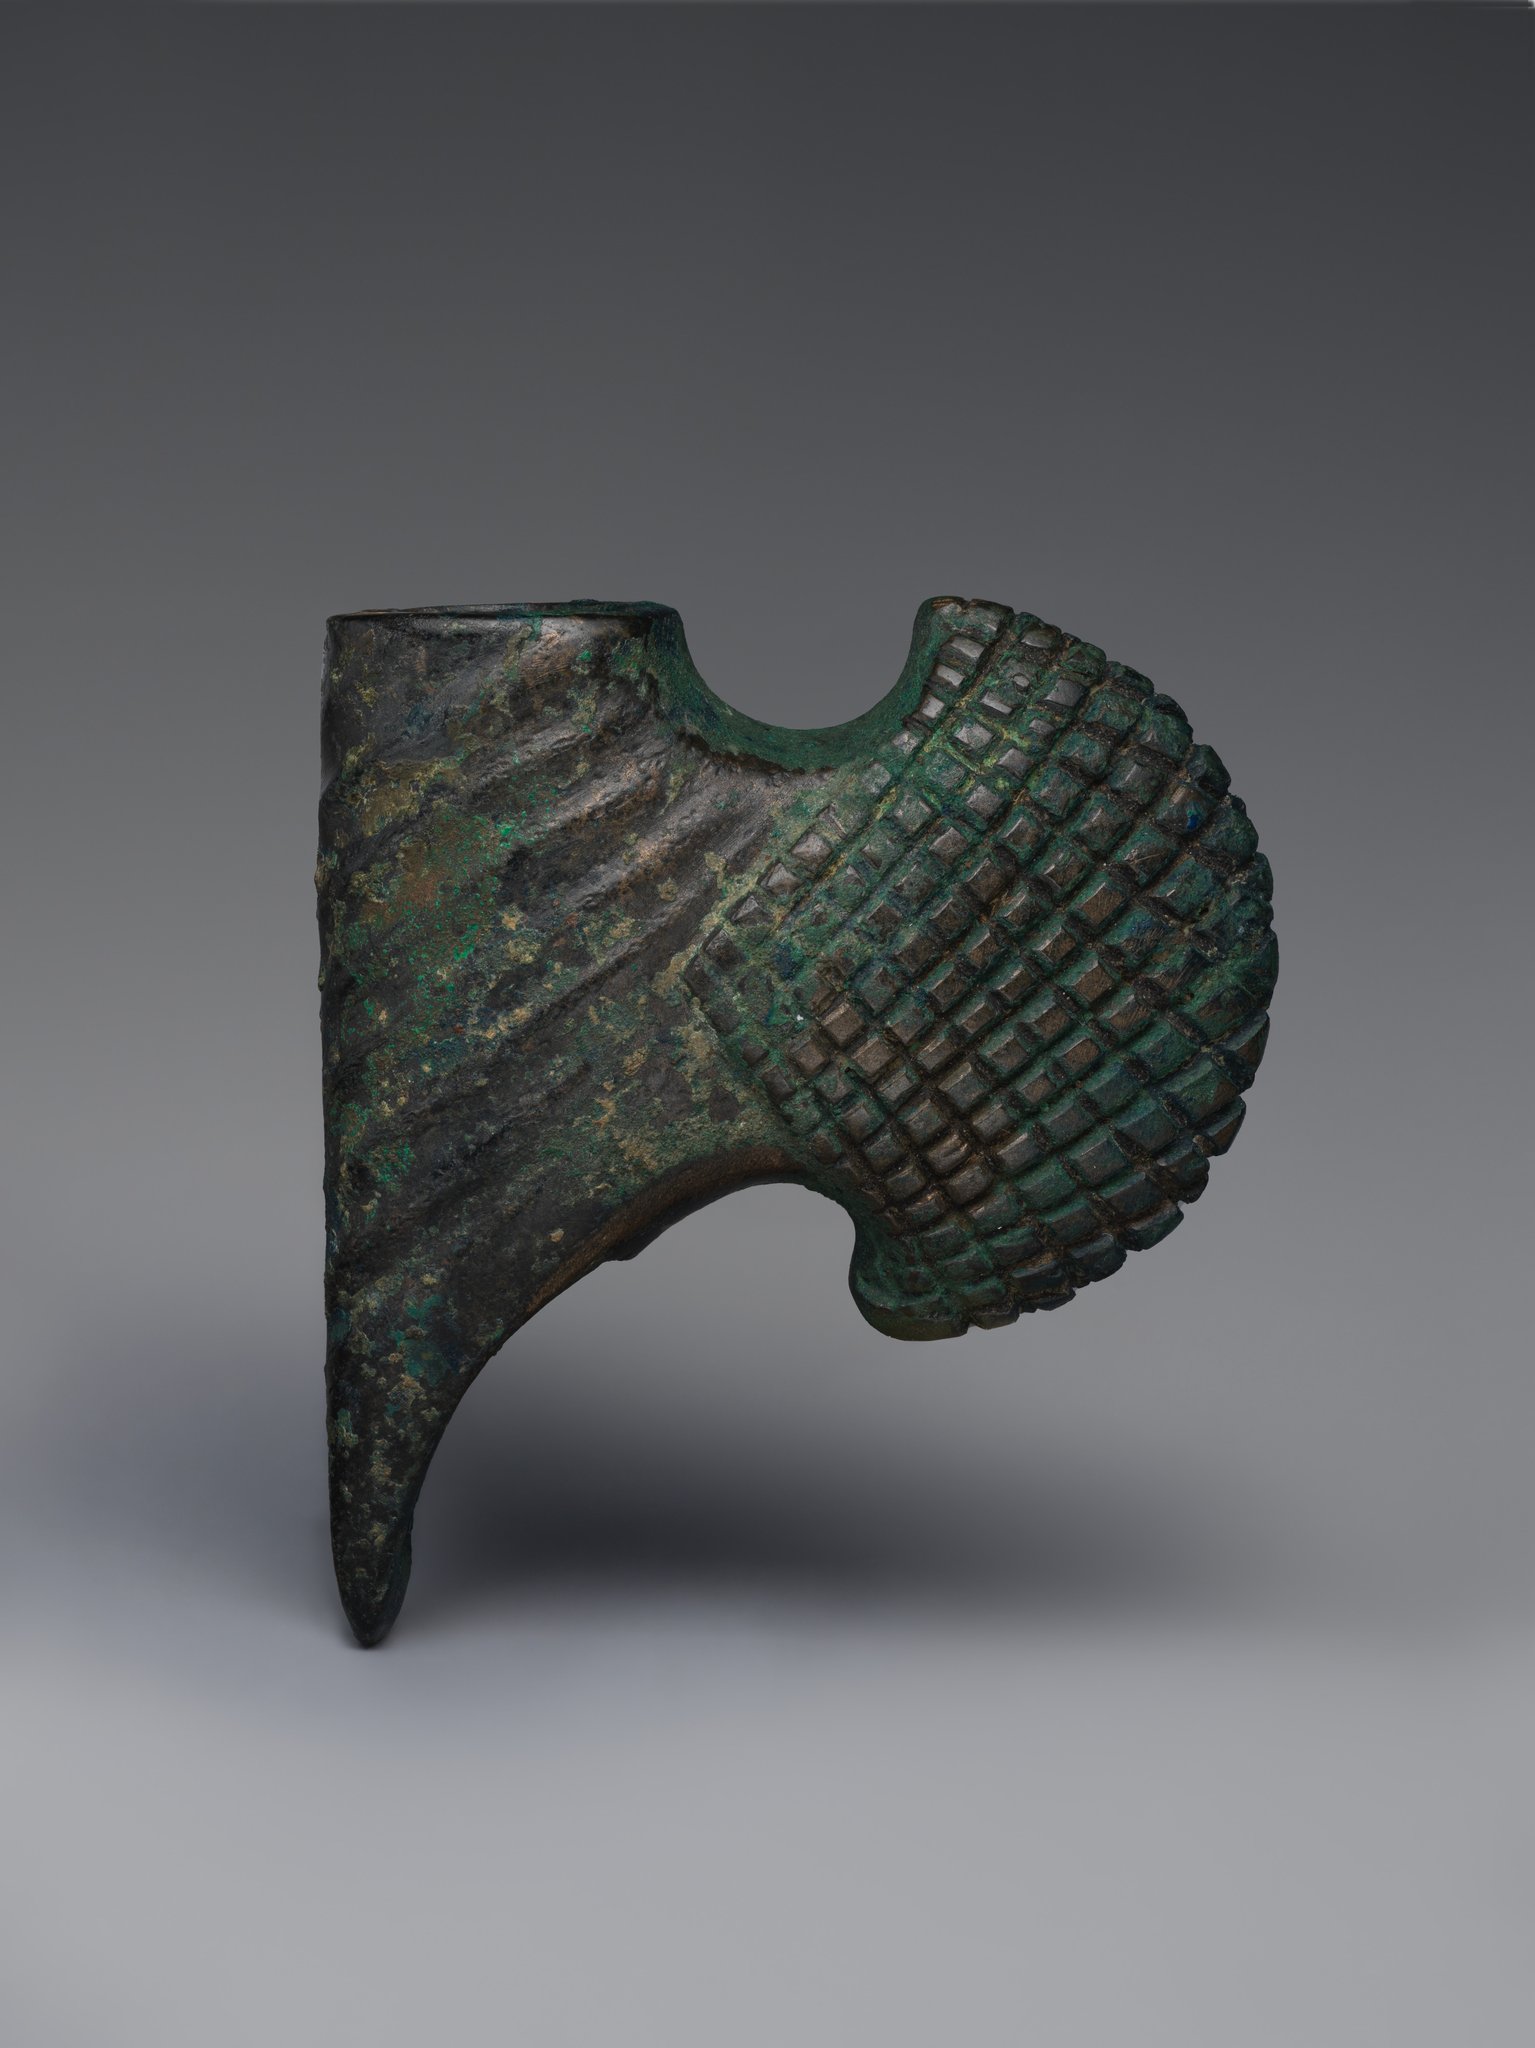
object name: mace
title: Mace head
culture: hattian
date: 2300-2000 BCE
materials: bronze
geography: central anatolia